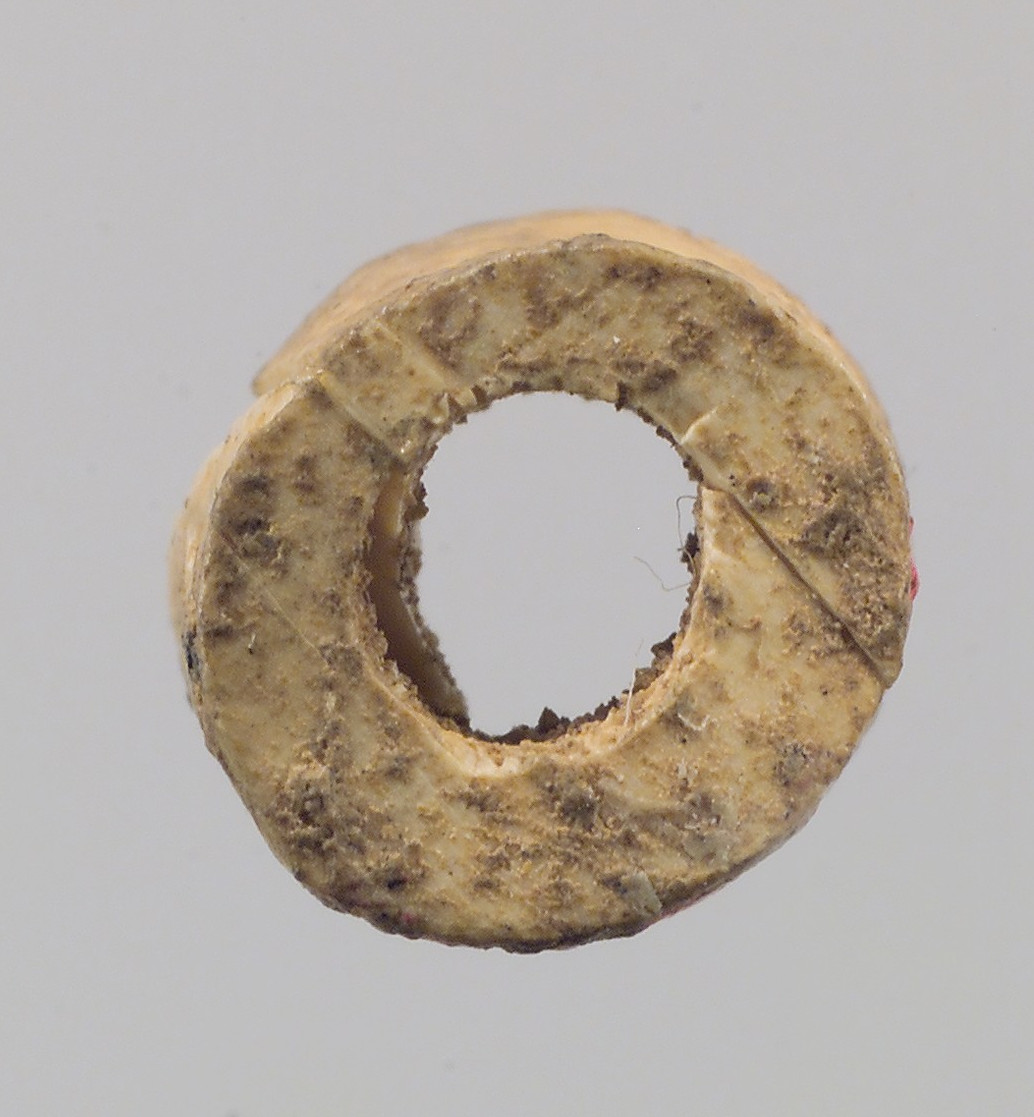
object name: inlay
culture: iranian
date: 800-601 BCE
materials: ivory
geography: iran